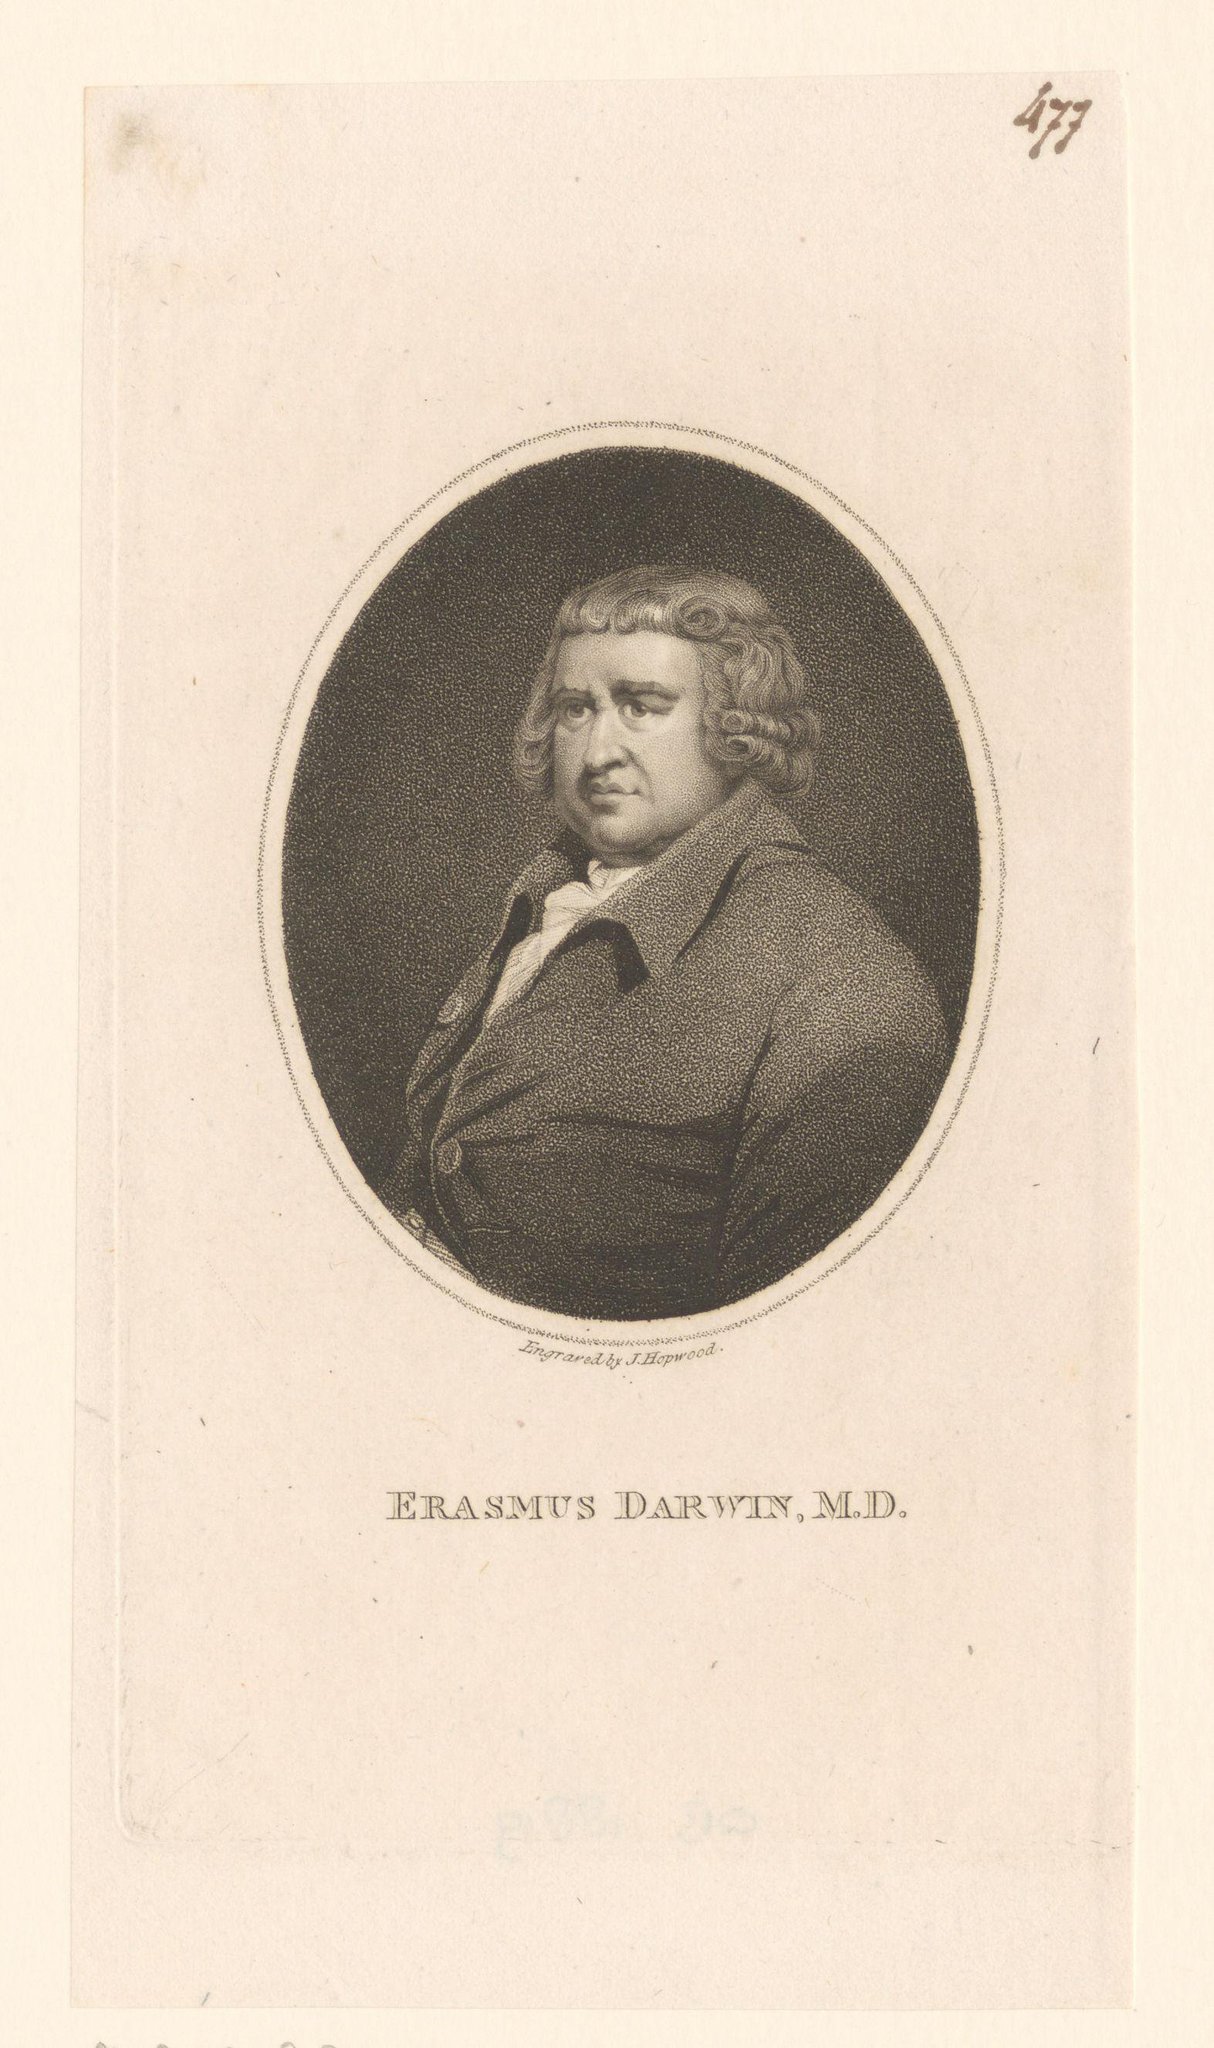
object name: print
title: Portret van Erasmus Darwin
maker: james hopwood (i)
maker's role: print maker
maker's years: 1752-1819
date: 1792-1819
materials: paper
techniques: etching, engraving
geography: england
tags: physicist, historical persons, physician, doctor (+ portrait of scholar, scientist), scholar, philosopher (+ portrait of scholar, scientist)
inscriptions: inscription: ‘477’, collector's mark: Lugt 2228